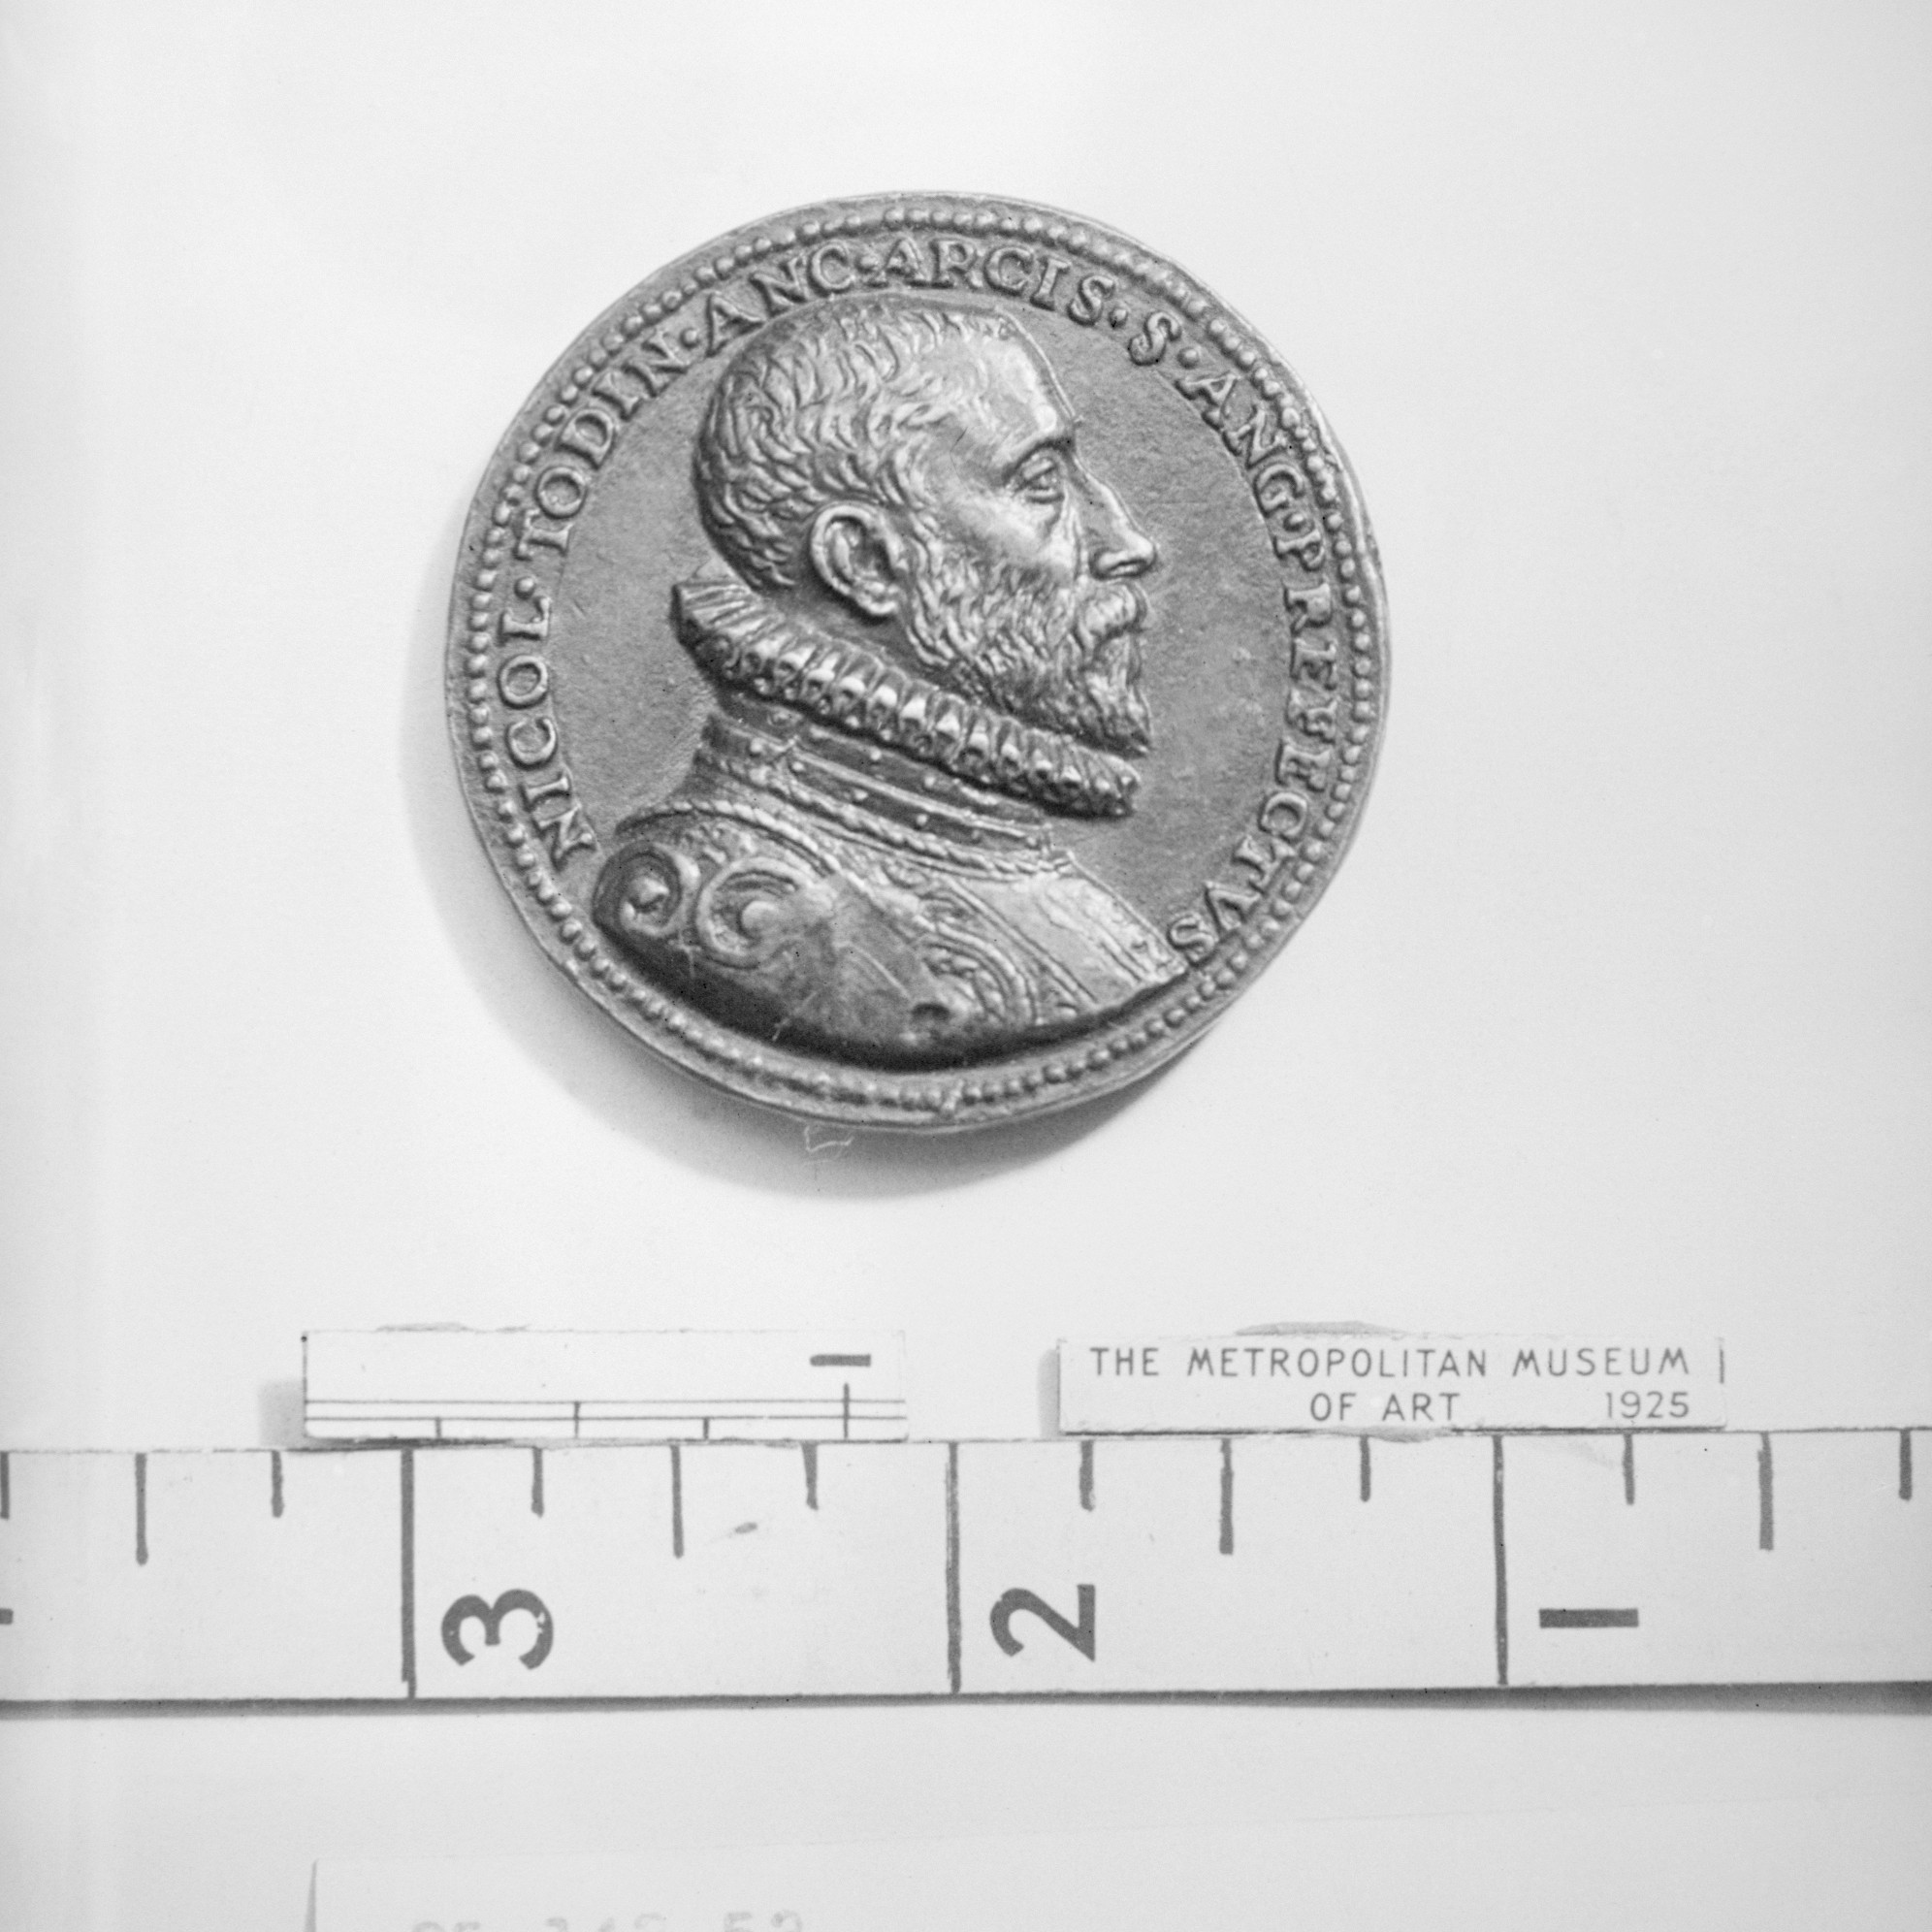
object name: medal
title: Nicolo Todini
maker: domenico poggini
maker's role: artist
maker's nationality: italian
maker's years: 1520-1590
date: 1501-1600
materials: bronze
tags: men,profiles